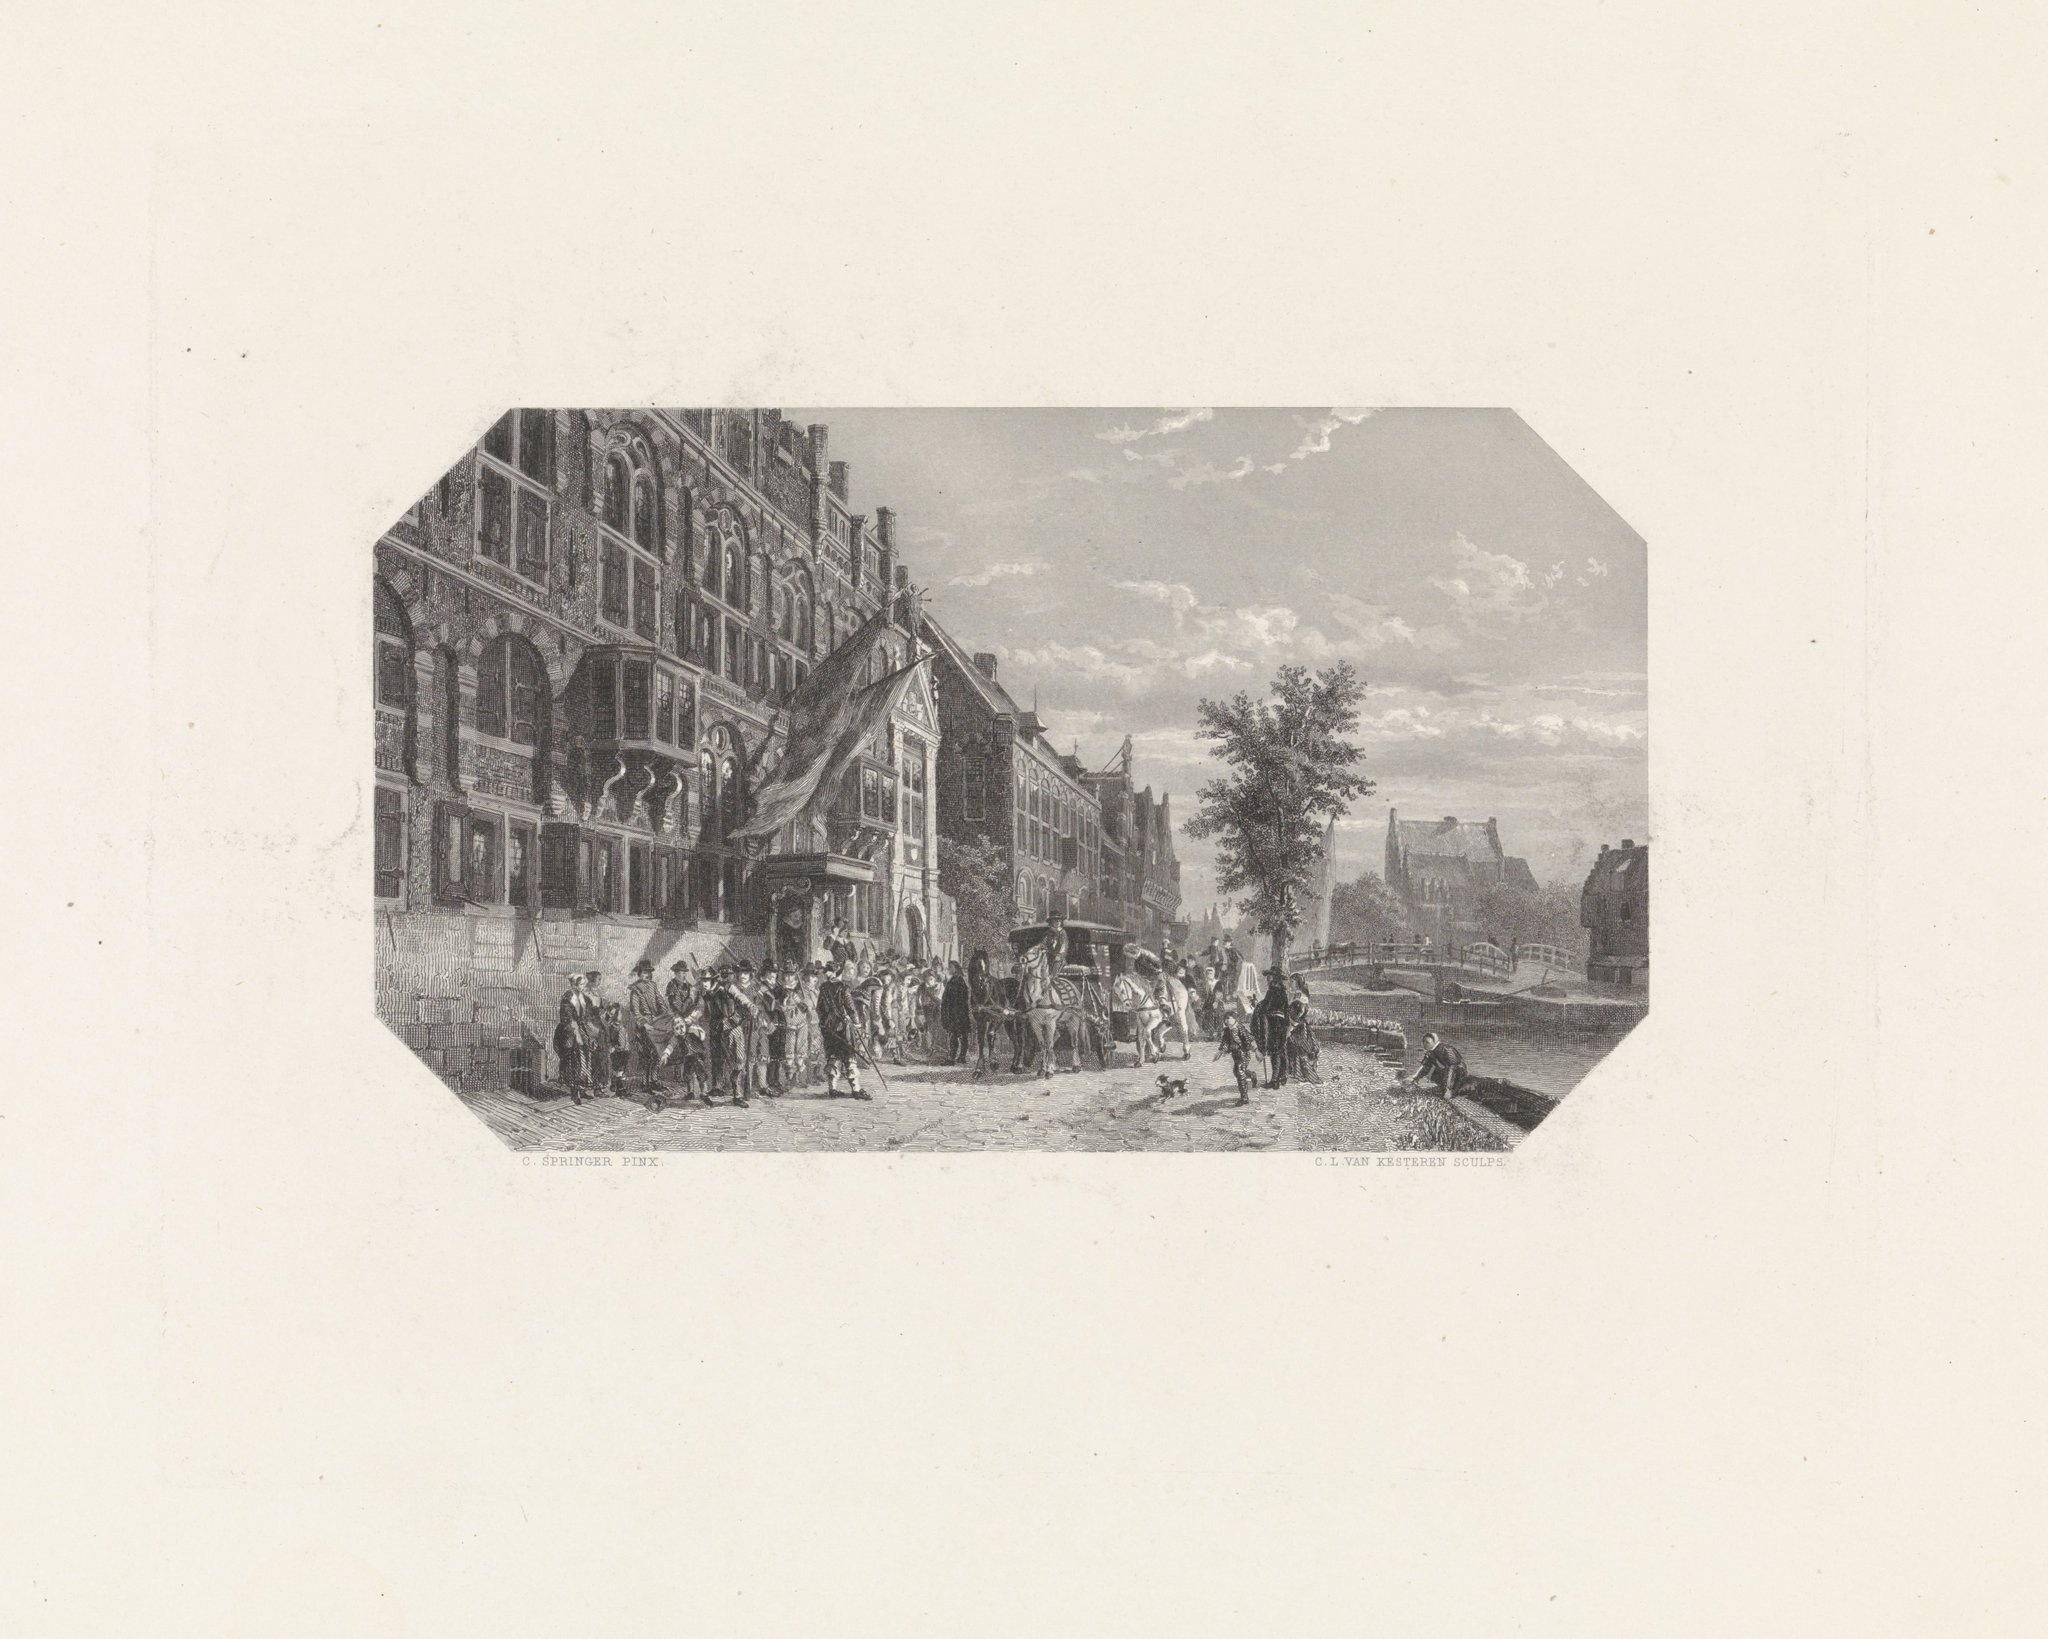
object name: print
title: Schuttersdoelen te Amsterdam, ca 1650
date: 1870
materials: paper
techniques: engraving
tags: city-view in general; 'veduta', four-wheeled vehicle drawn by two animals, dog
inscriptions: collector's mark: Lugt 2228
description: Twee schuttersdoelen te Amsterdam, de Handboogdoelen en de Voetboogdoelen, ca. 1650. Bij de met twee vlaggen versierde ingang een uitgespannen koets en tal van mensen. Rechts, spelende kinderen met een hondje en de gracht. Op de achtergrond een brug.